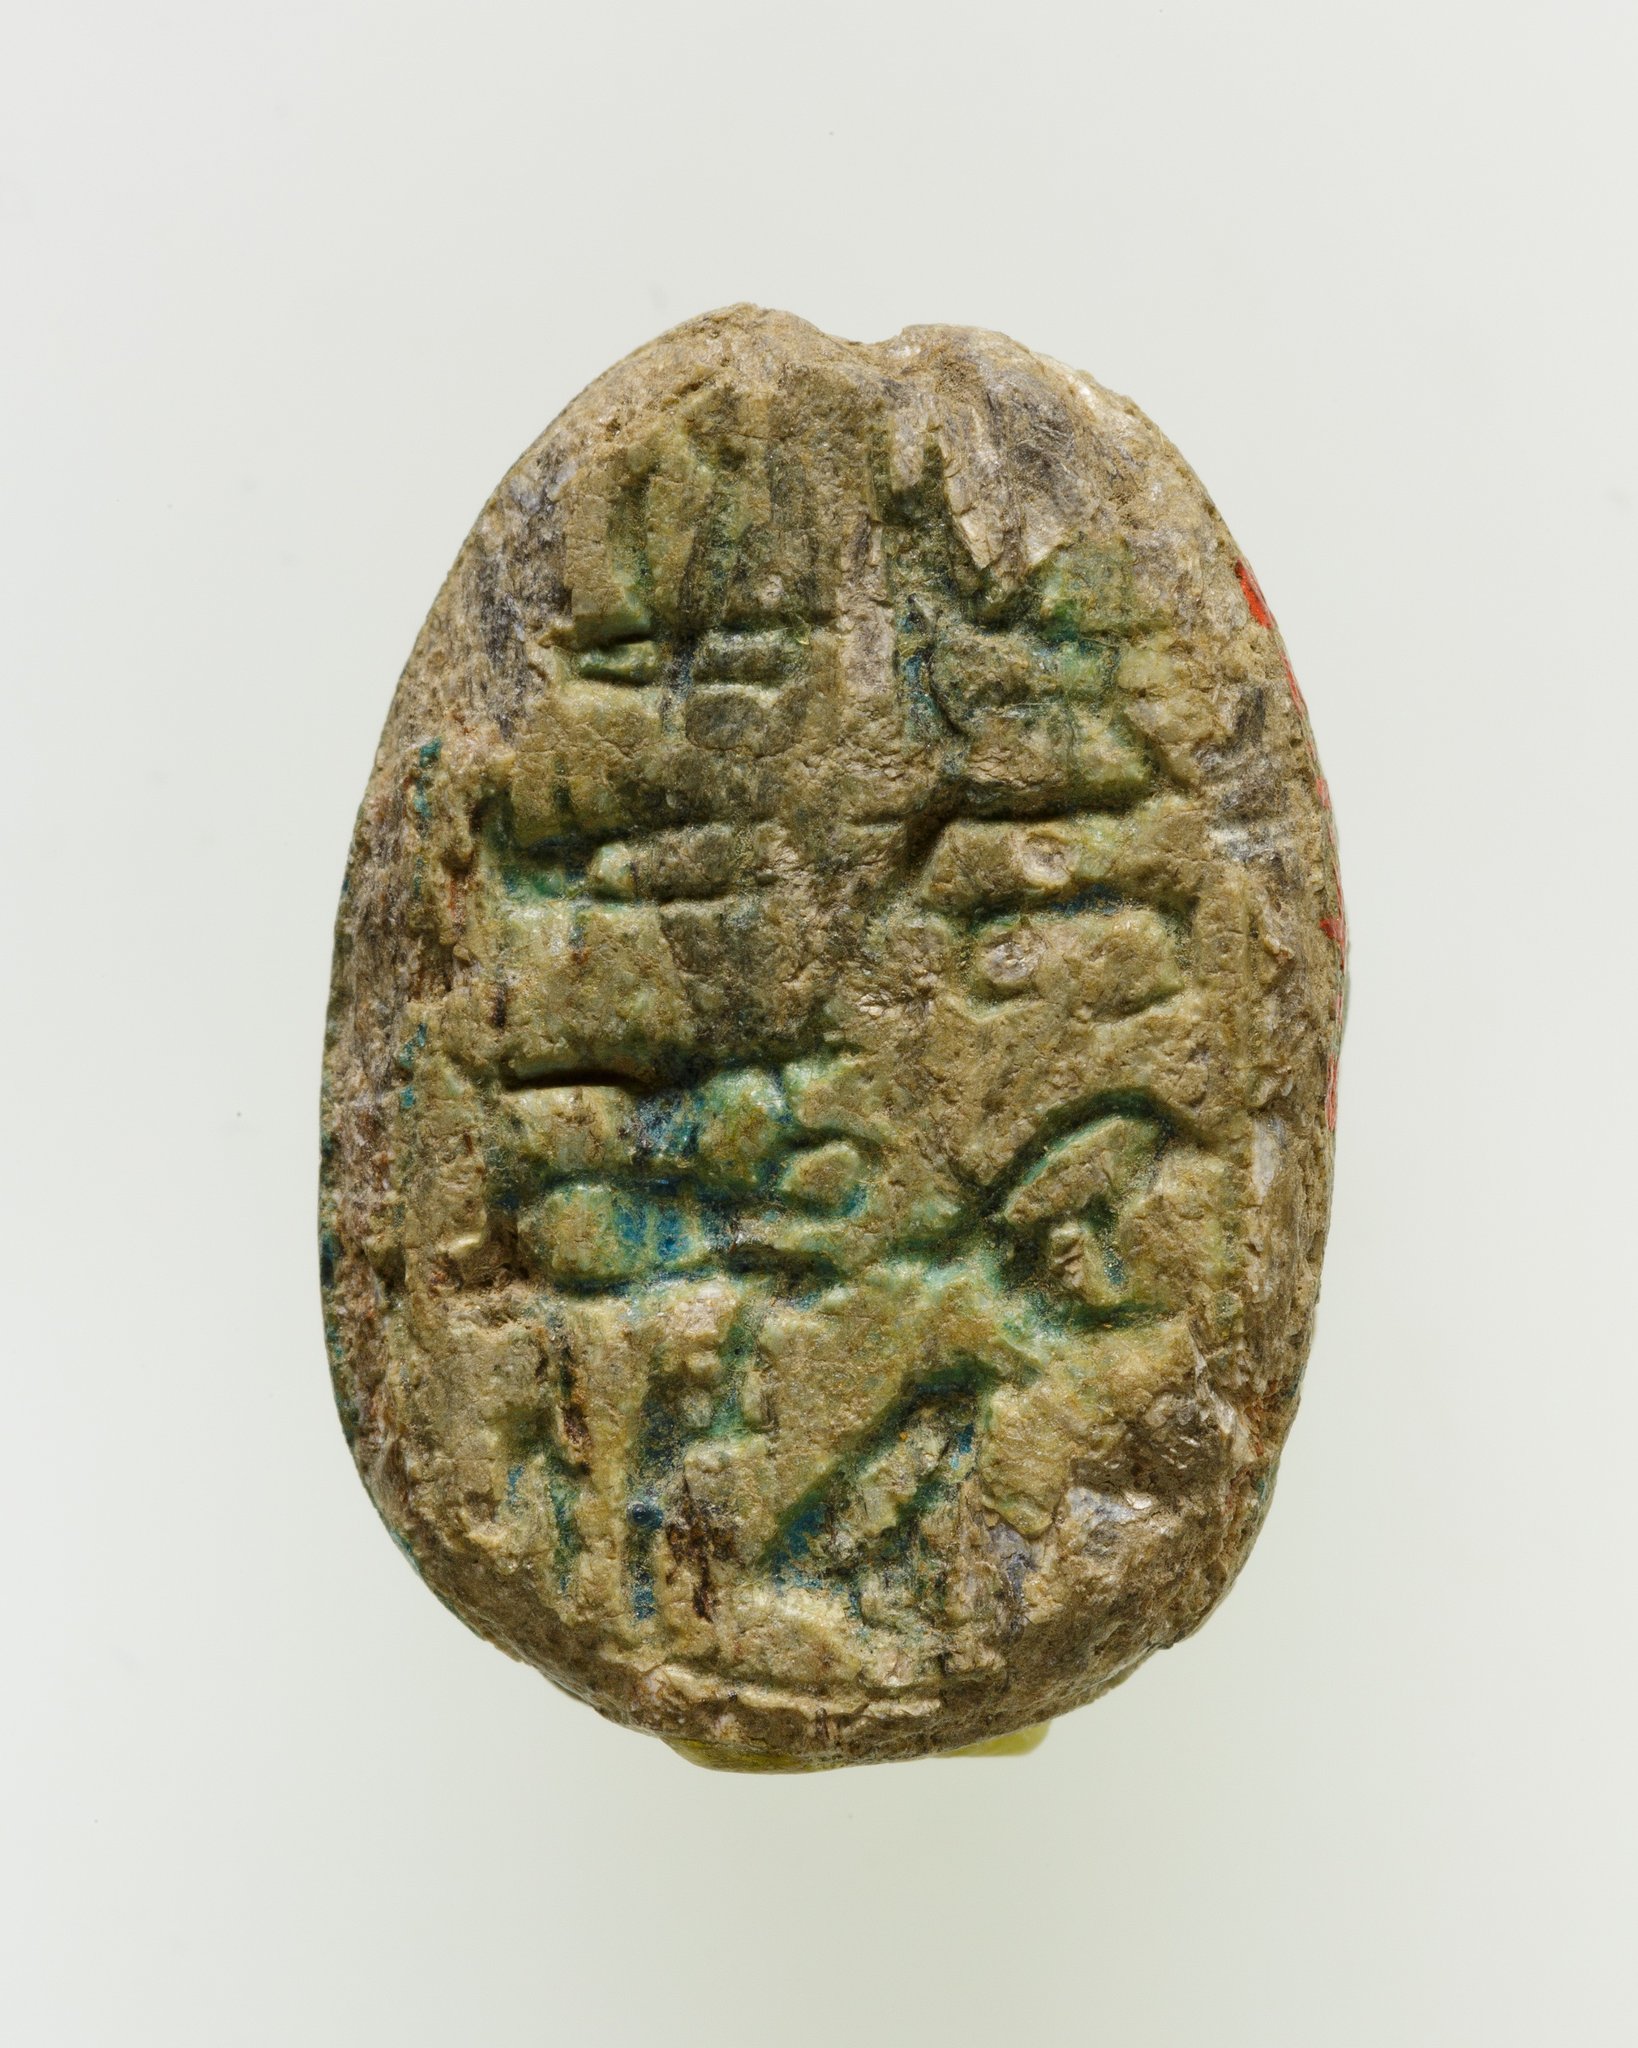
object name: scarab, official, private name and title, mentuuser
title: Scarab of an Official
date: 1760-1670 BCE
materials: stone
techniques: glazing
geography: egypt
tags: hieroglyphs,scarabs